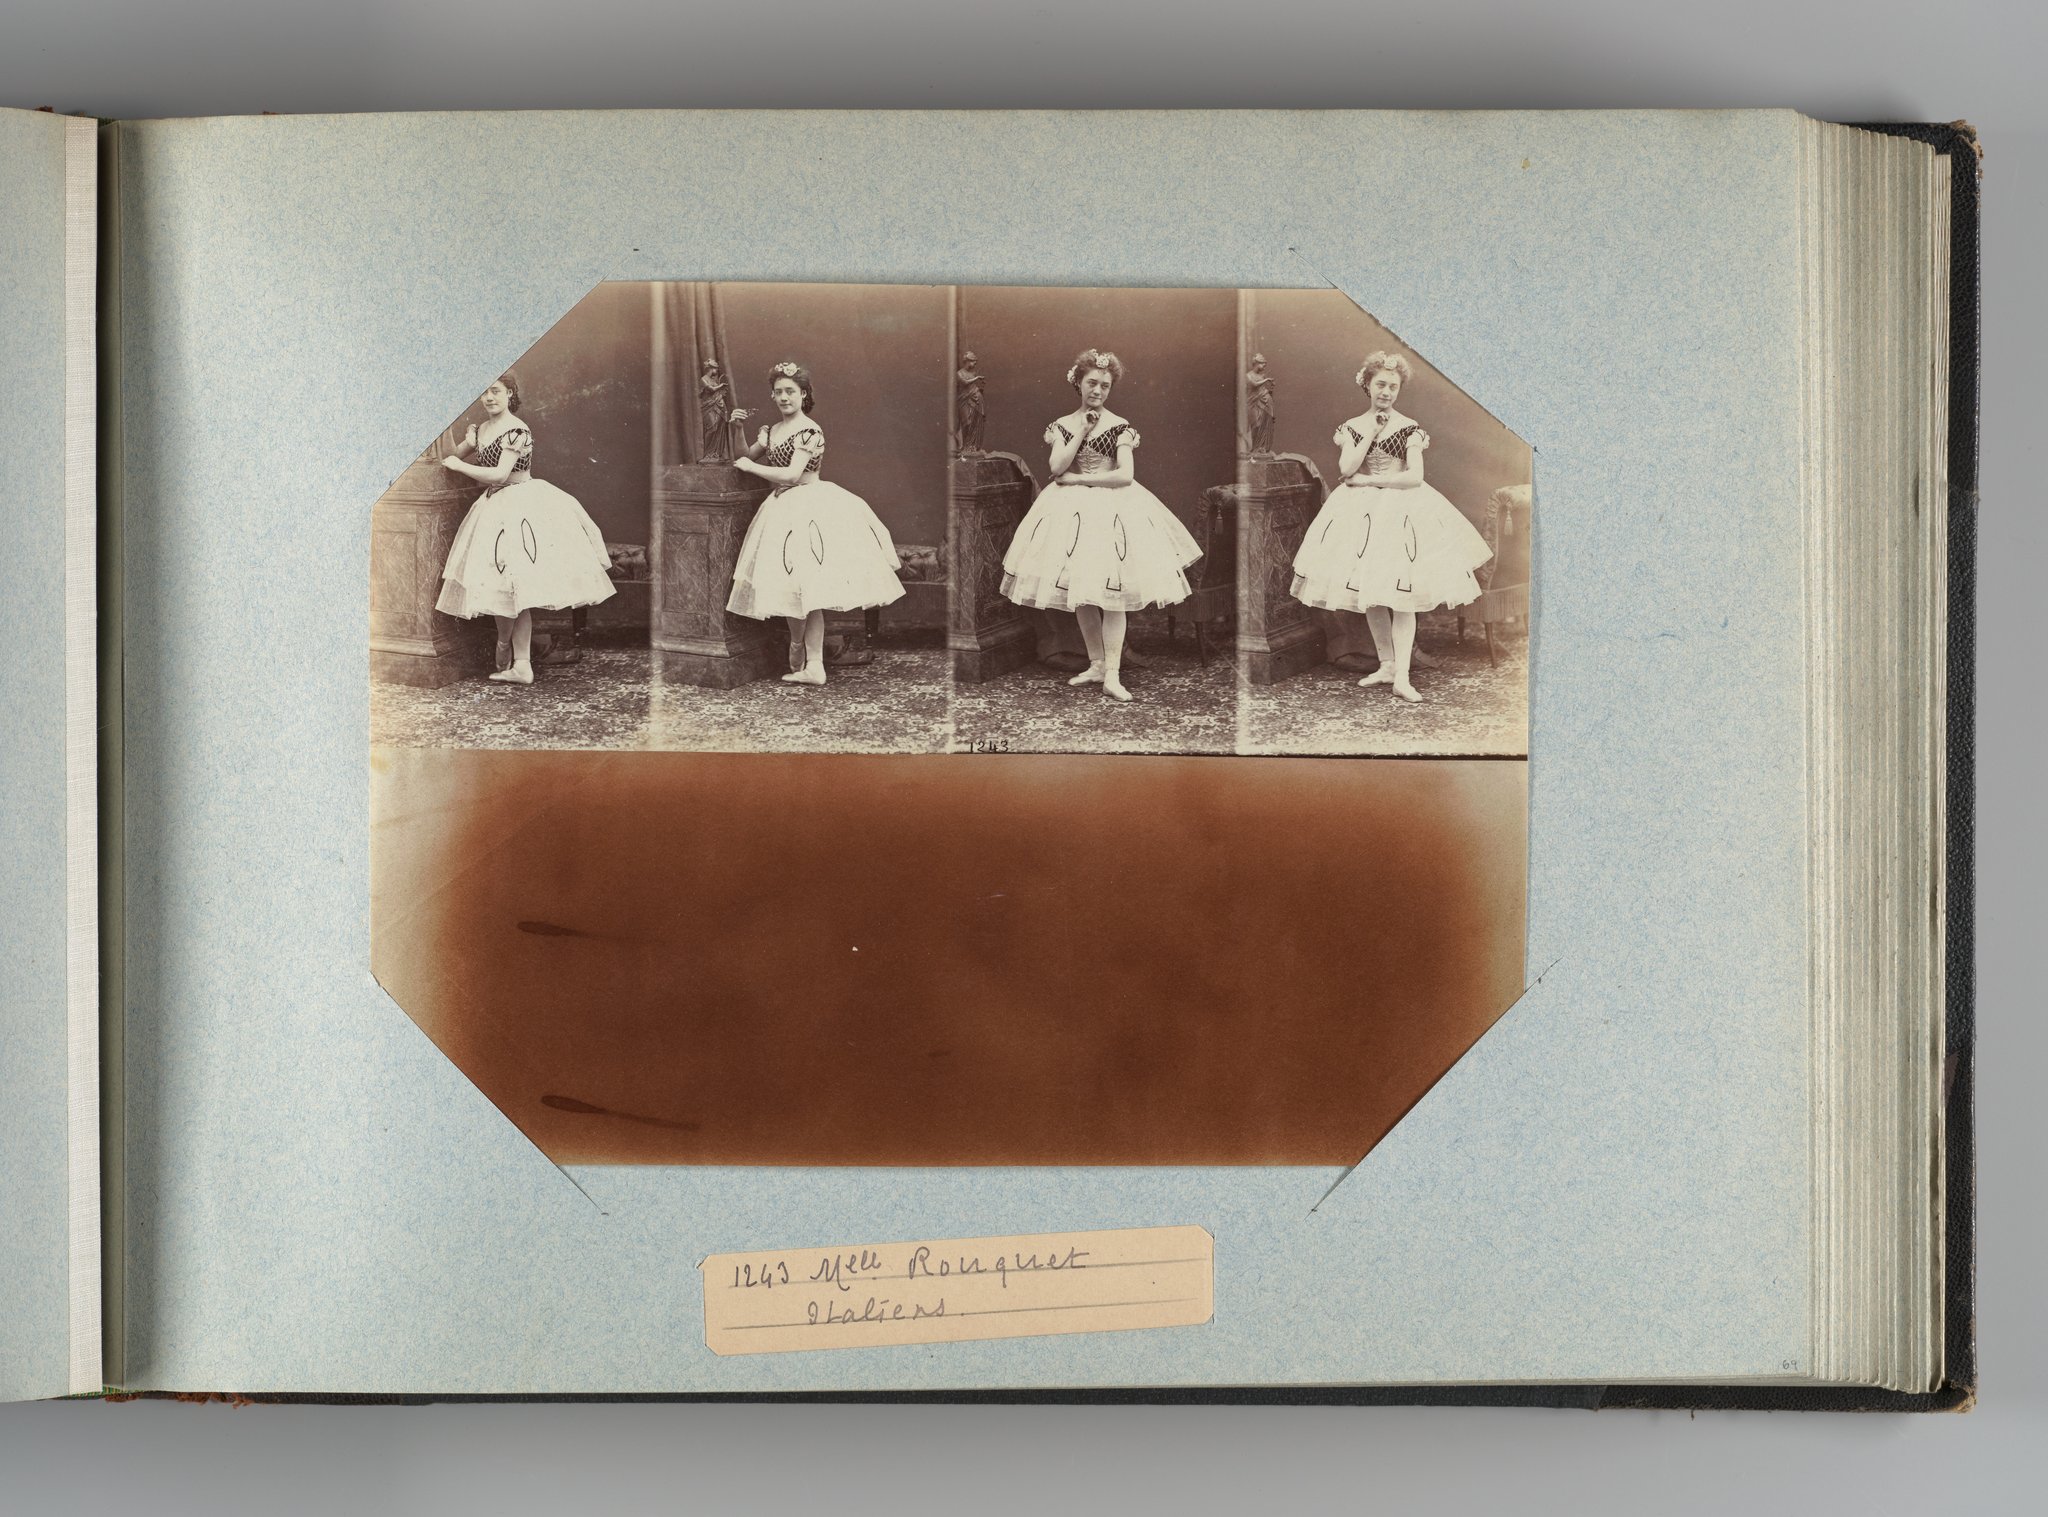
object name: photograph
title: Mlle Rouquet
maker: andré-adolphe-eugène disdéri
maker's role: artist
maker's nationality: french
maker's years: 1819-1889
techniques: albumen silver print, glass negative